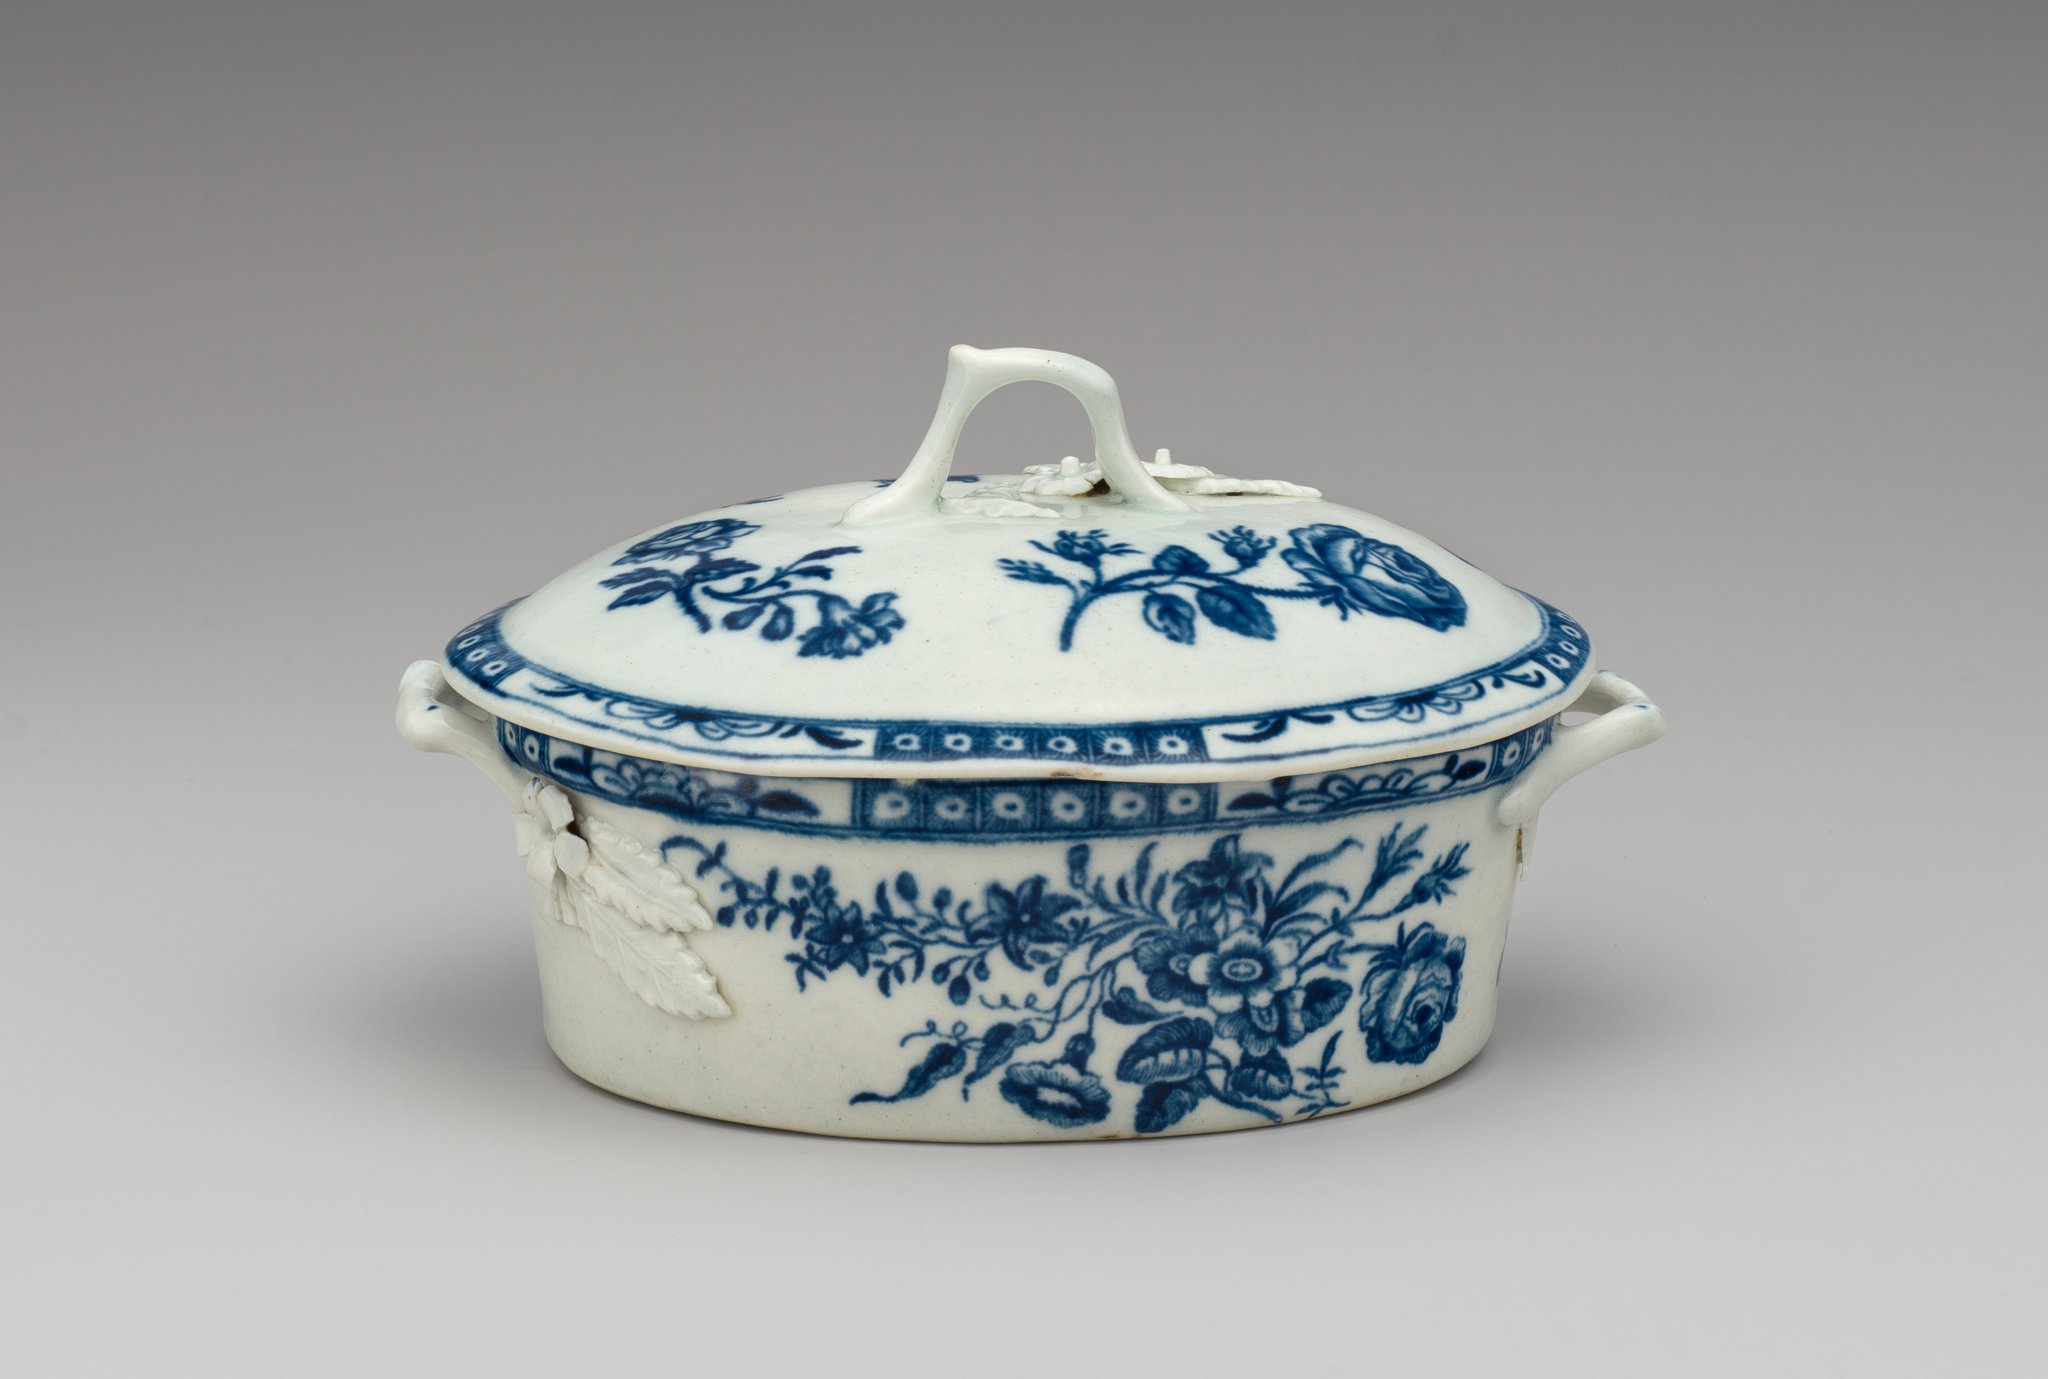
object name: butter dish with cover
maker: worcester factory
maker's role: factory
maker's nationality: british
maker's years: 1751-2008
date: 1760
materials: soft paste porcelain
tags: flowers